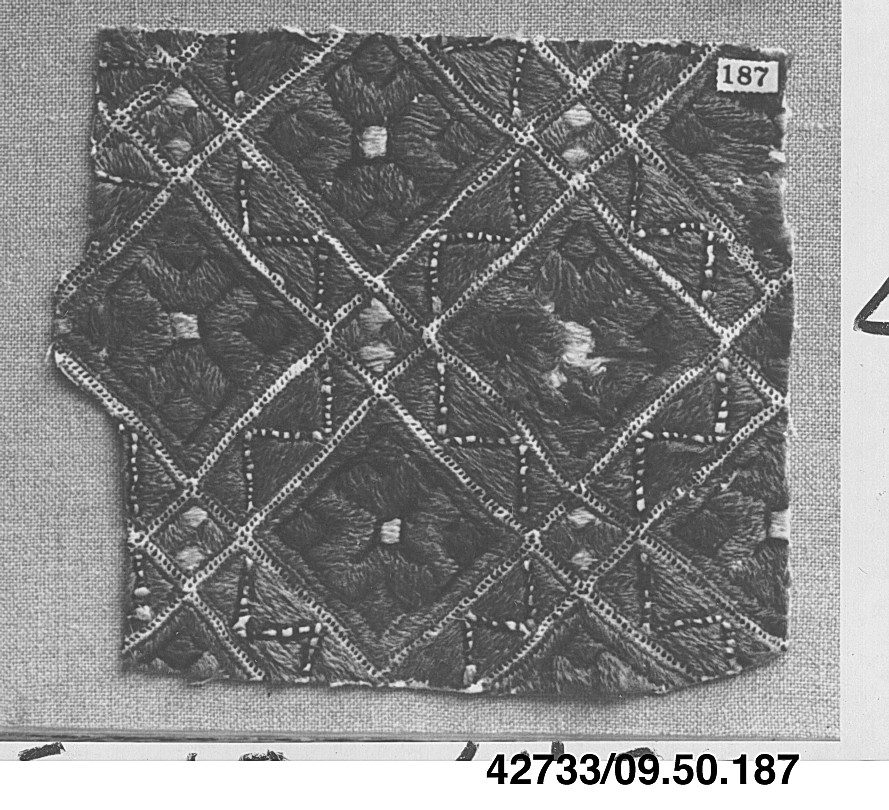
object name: costume fragment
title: Peasant costume fragment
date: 1701-1900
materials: canvas, wool